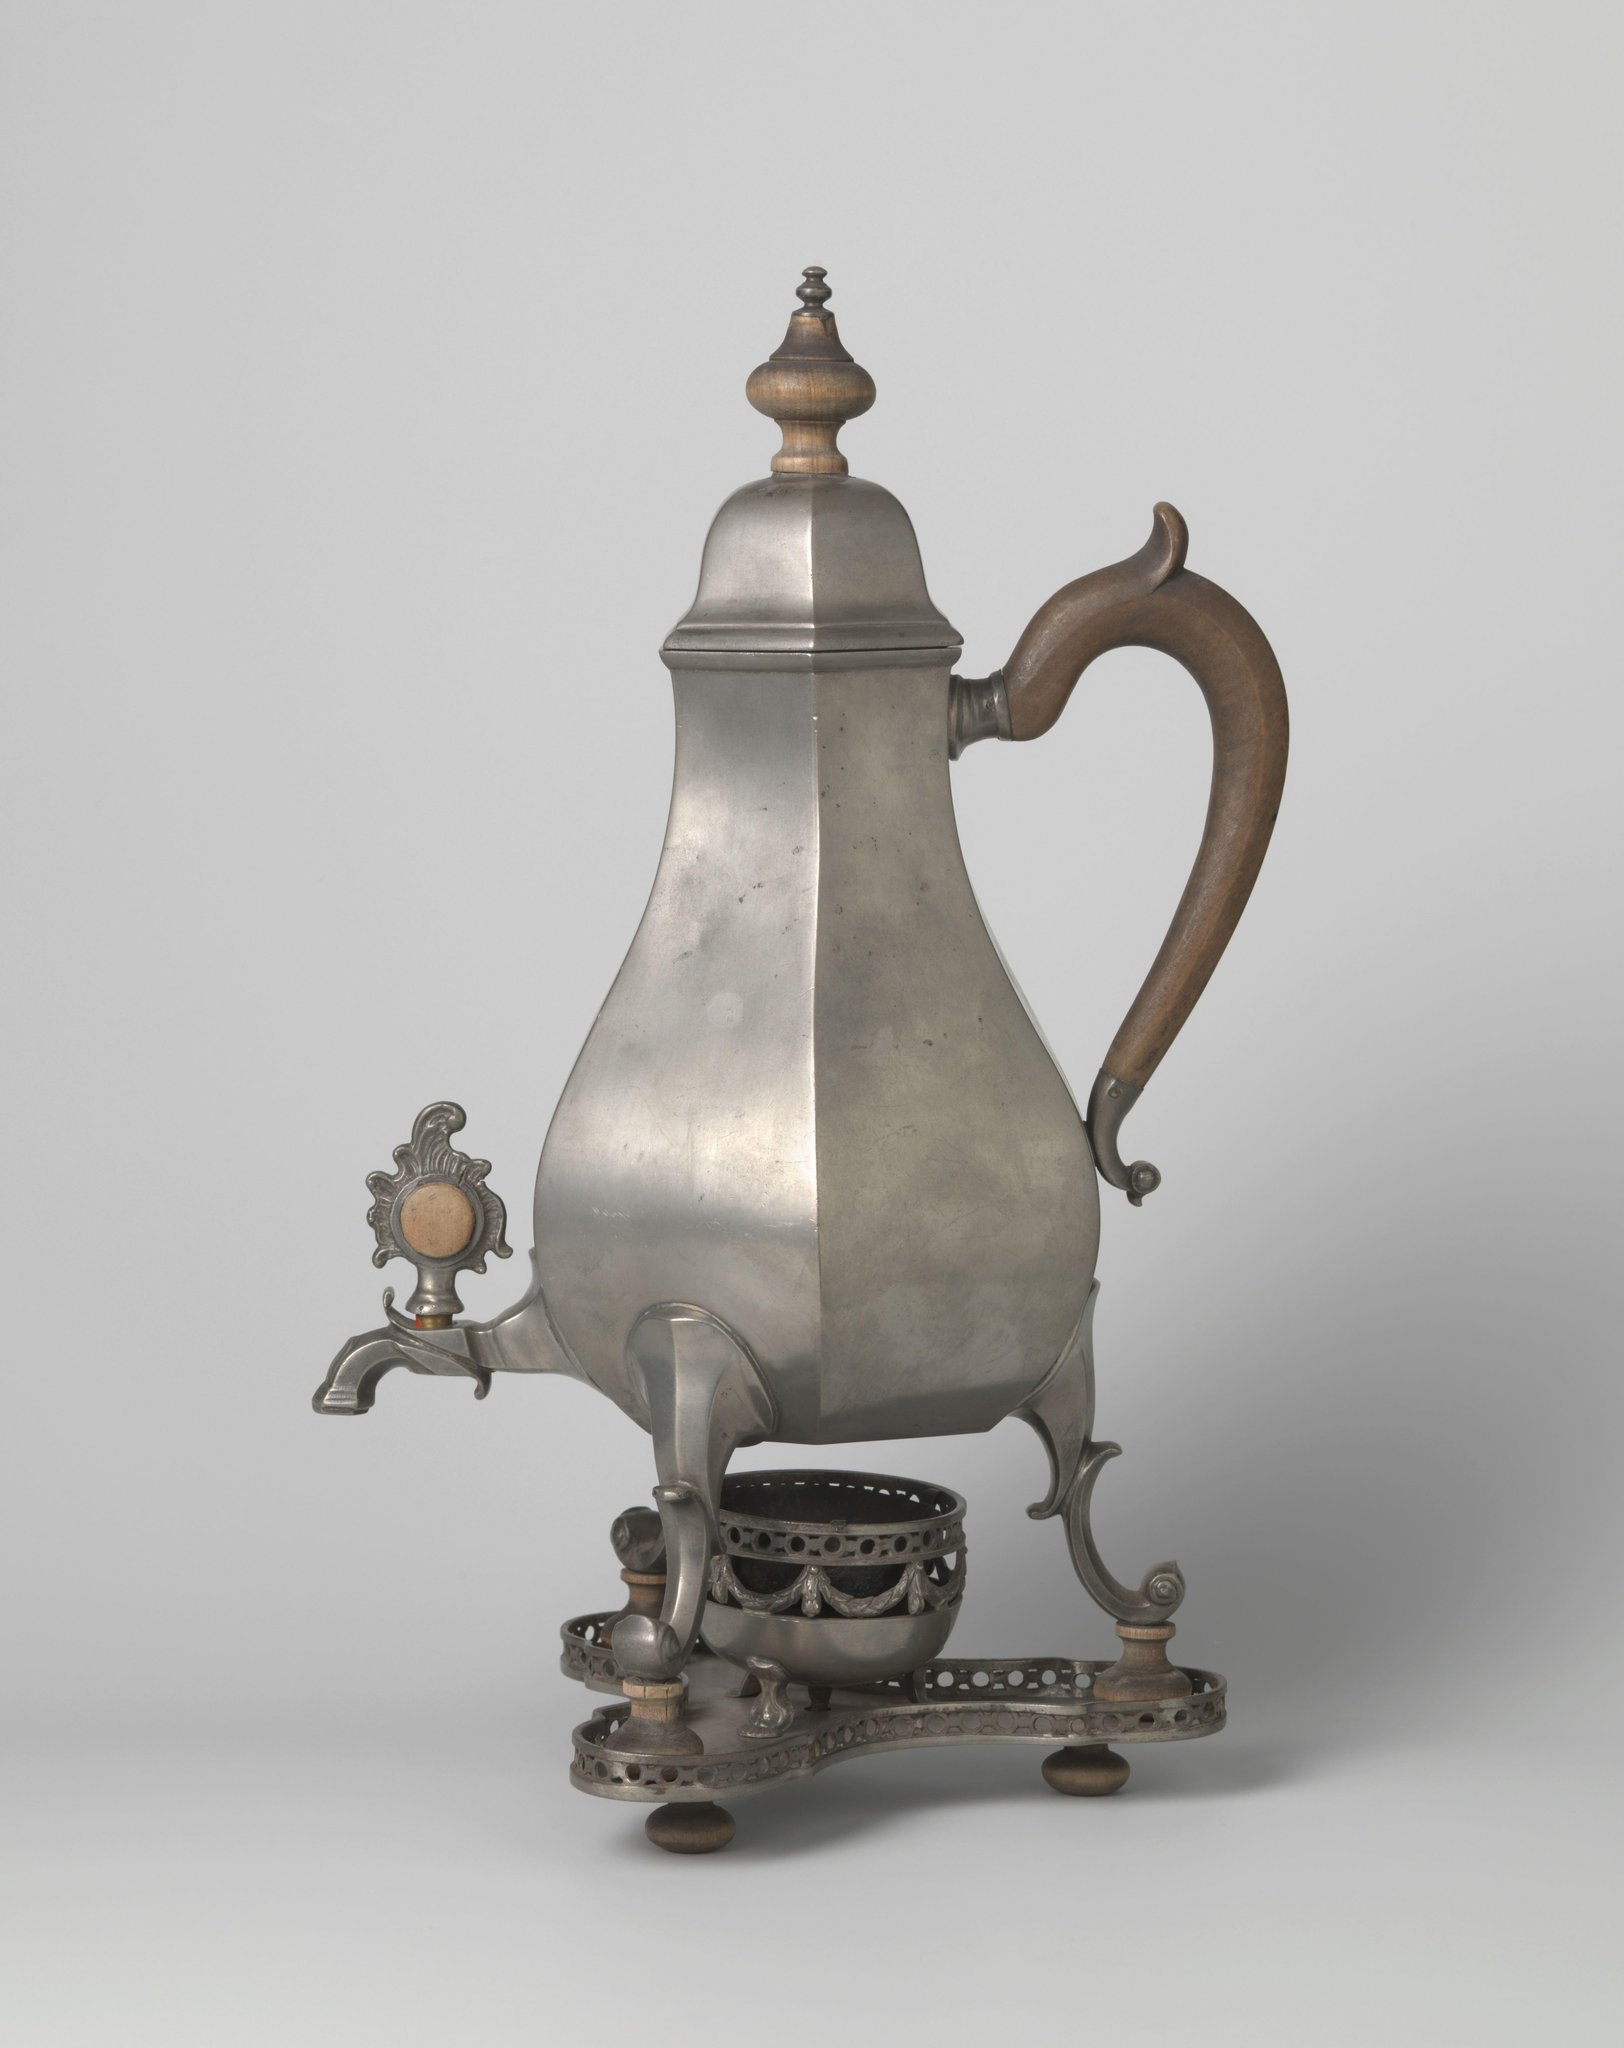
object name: onderstel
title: Kraantjeskan met deksel, en bijbehorend onderblad, van tin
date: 1720-1812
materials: tin, wood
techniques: casting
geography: amsterdam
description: Koffiekan van tin, een zogenaamde kraantjeskan. De poten zijn gevormd door voluten en rusten op houten bollen. Daarboven is de peervormige, zeshoekige kan. Net onder de liprand is het handvat aangebracht, dat doorloopt tot aan het breedste punt van de kan en deels van hout is. Onderaan de buik is het kraantje. Het losse deksel is zeshoekig en heeft een houten knop. Bij de kan hoort een blad van tin dat dient als onderstel. Op de drie houten pootjes ligt een blad met een opstaande, opengewerkte band. Daar bovenop staat een komfoor op drie poten. De bovenrand van het comfoor is versierd met een opengewerkte band met guirlandes.